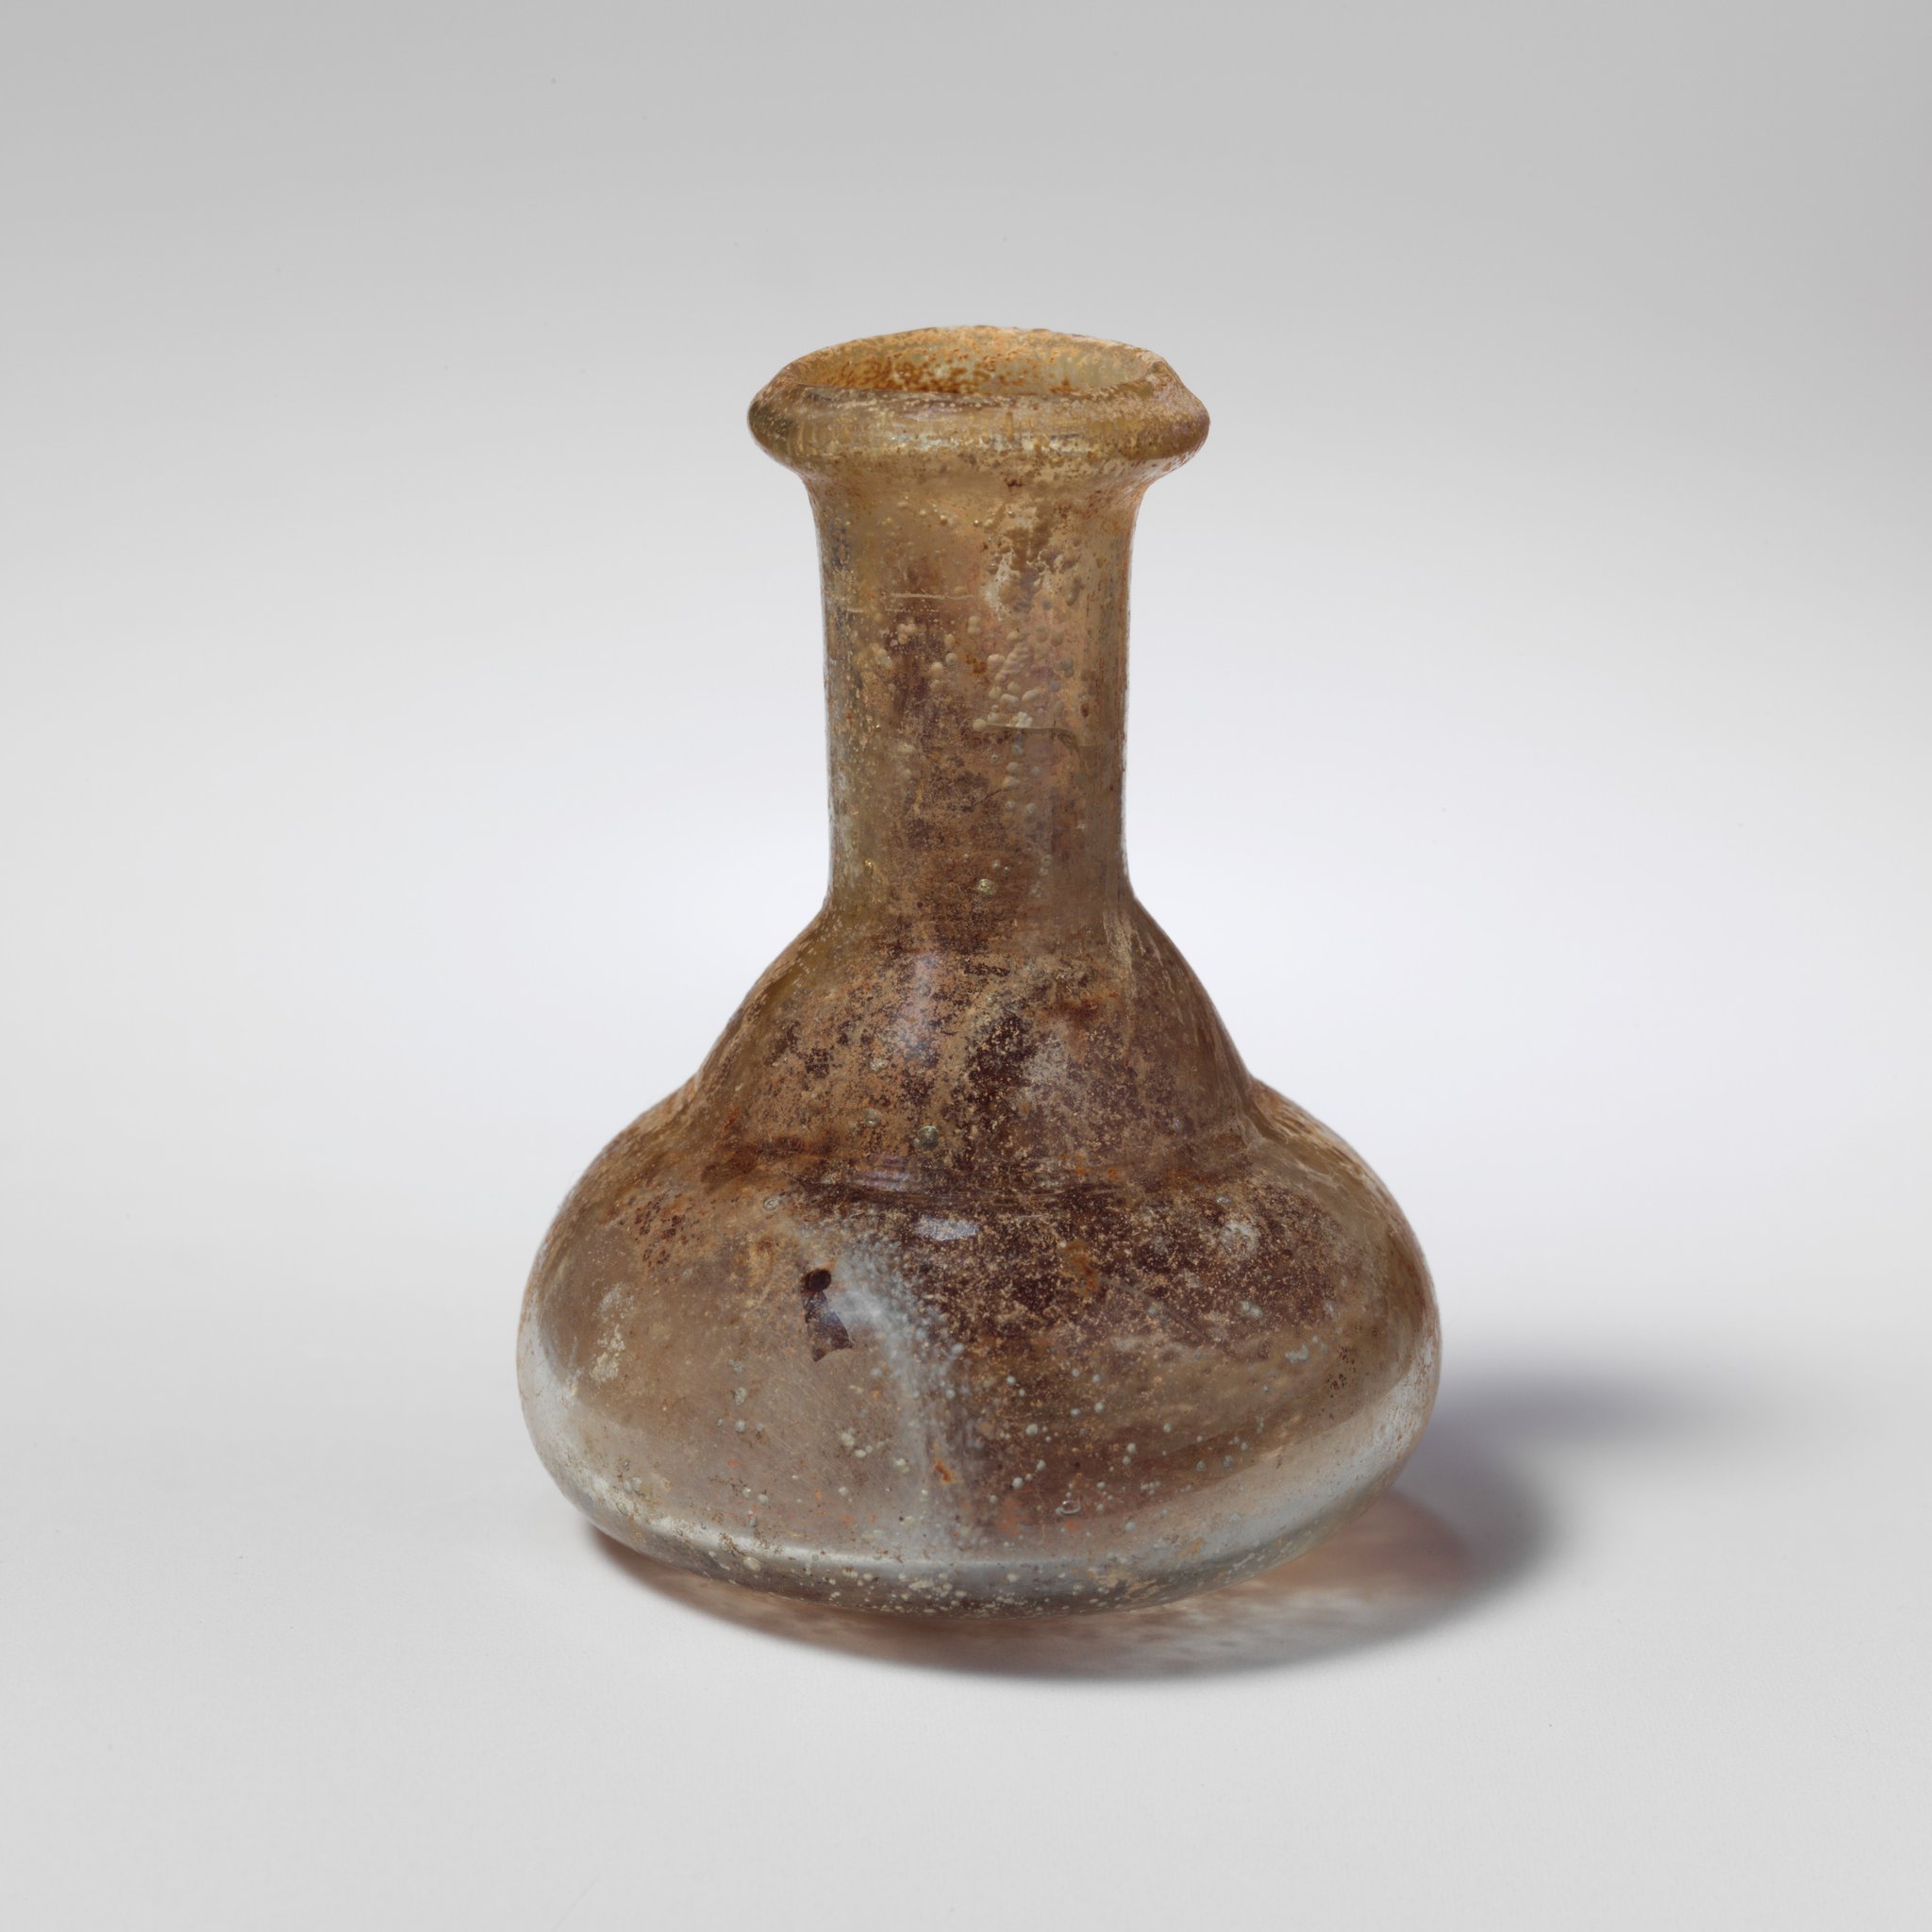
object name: perfume bottle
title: Glass perfume bottle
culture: roman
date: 1-100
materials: glass